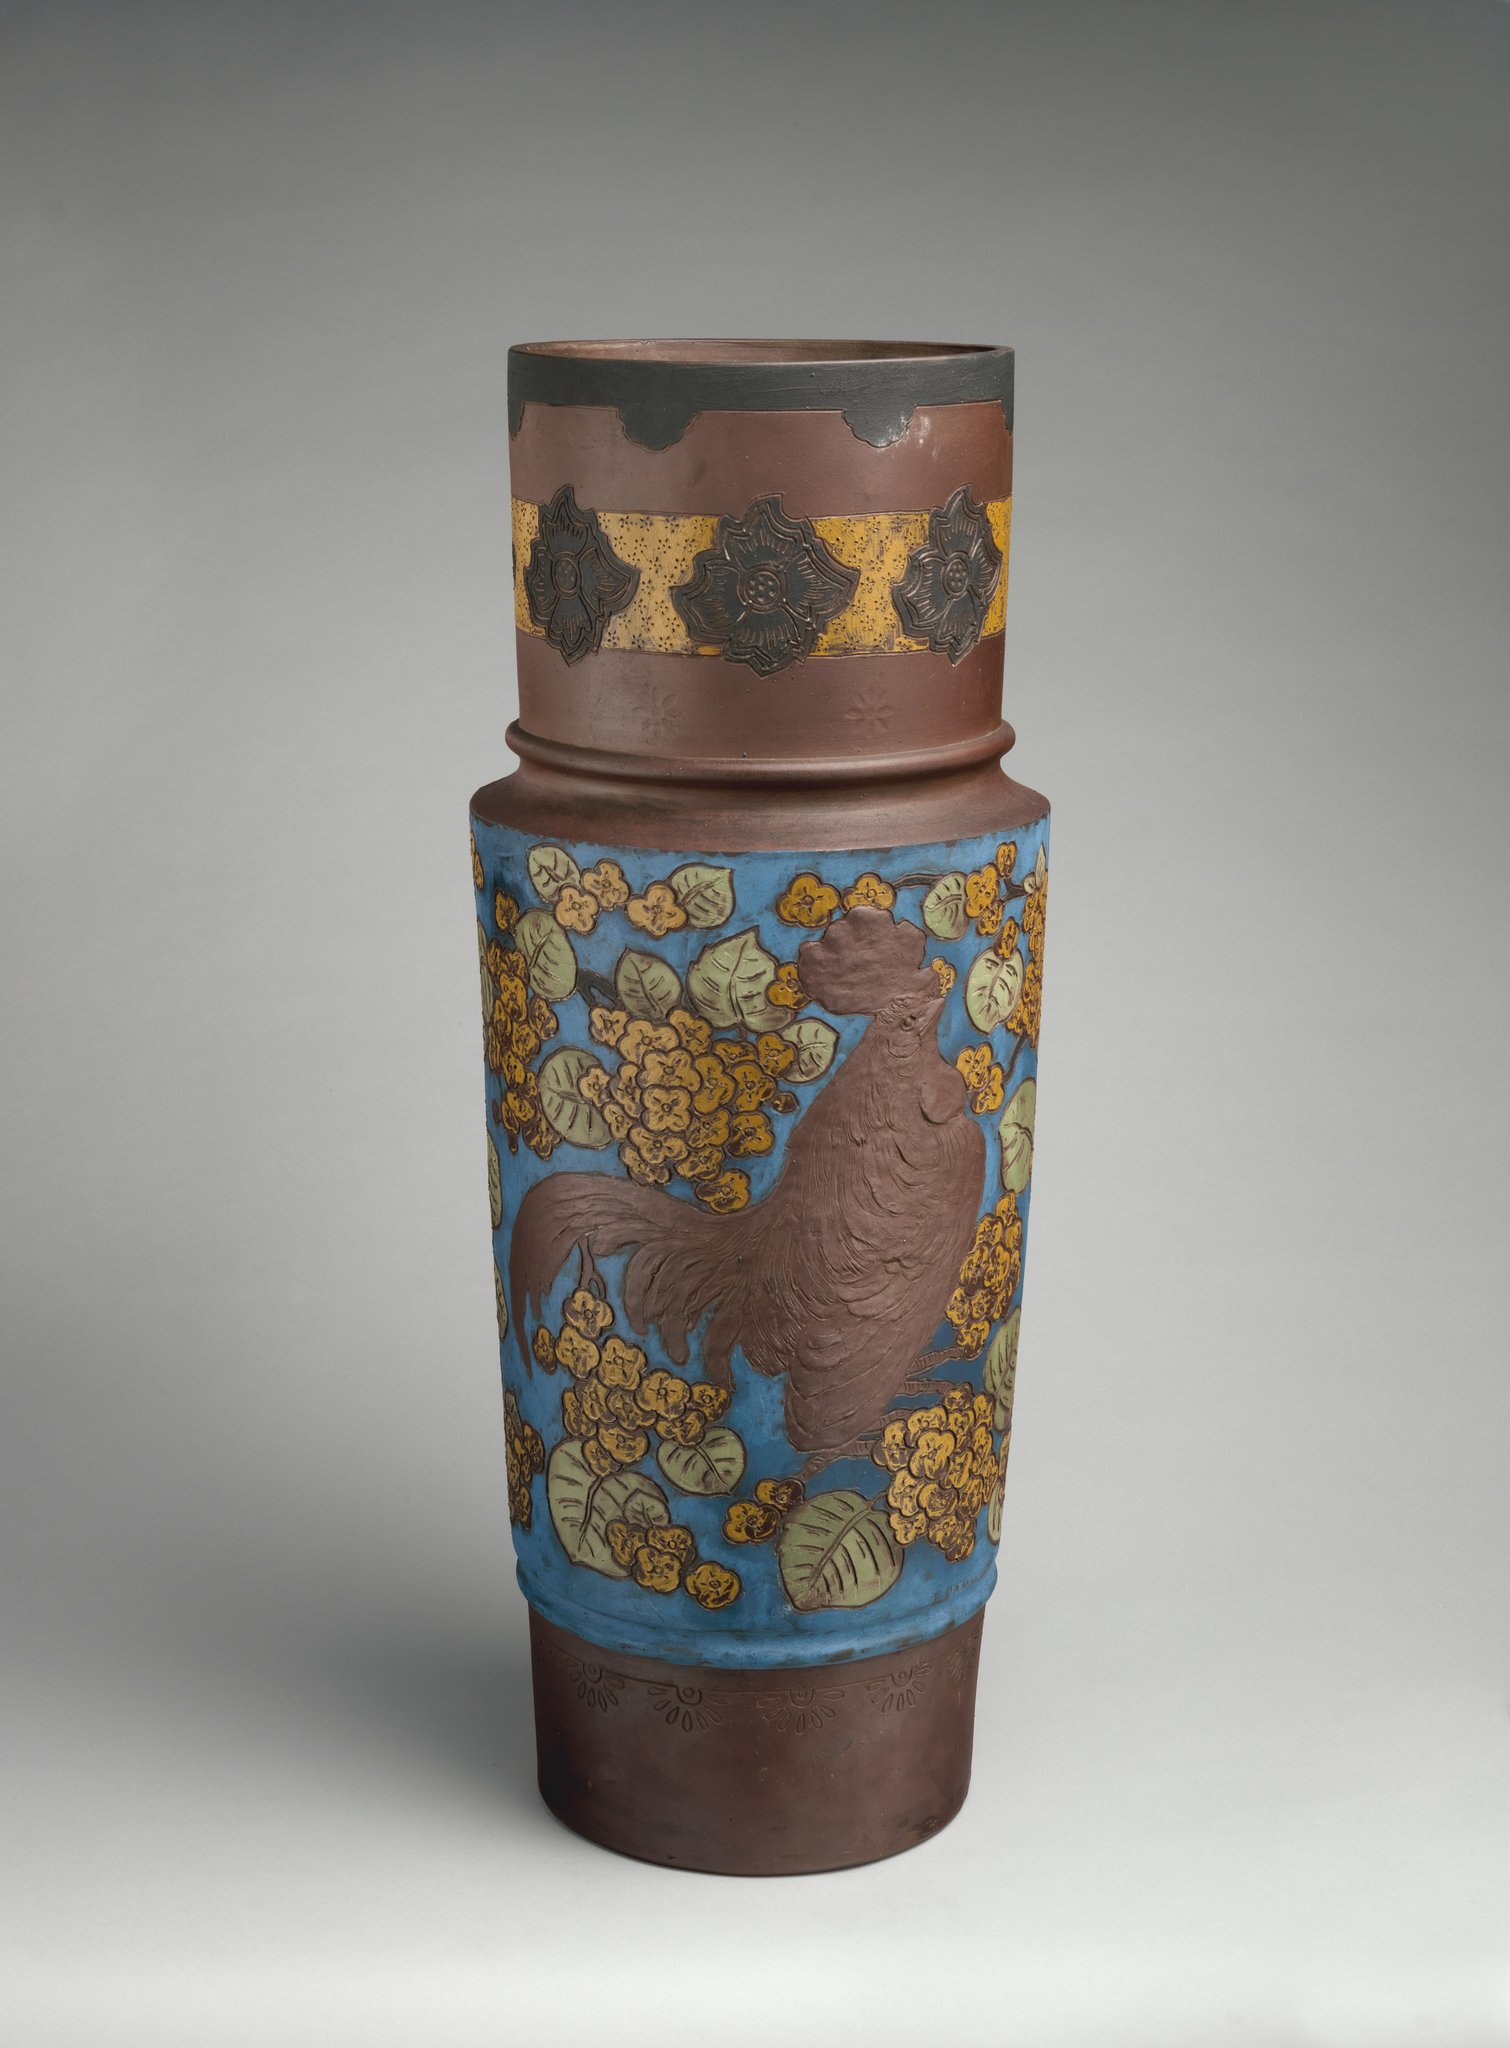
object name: vase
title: Vase with rooster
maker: haviland & co.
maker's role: manufactory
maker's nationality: american and french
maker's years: 1864-1931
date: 1884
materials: stoneware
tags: roosters,flowers